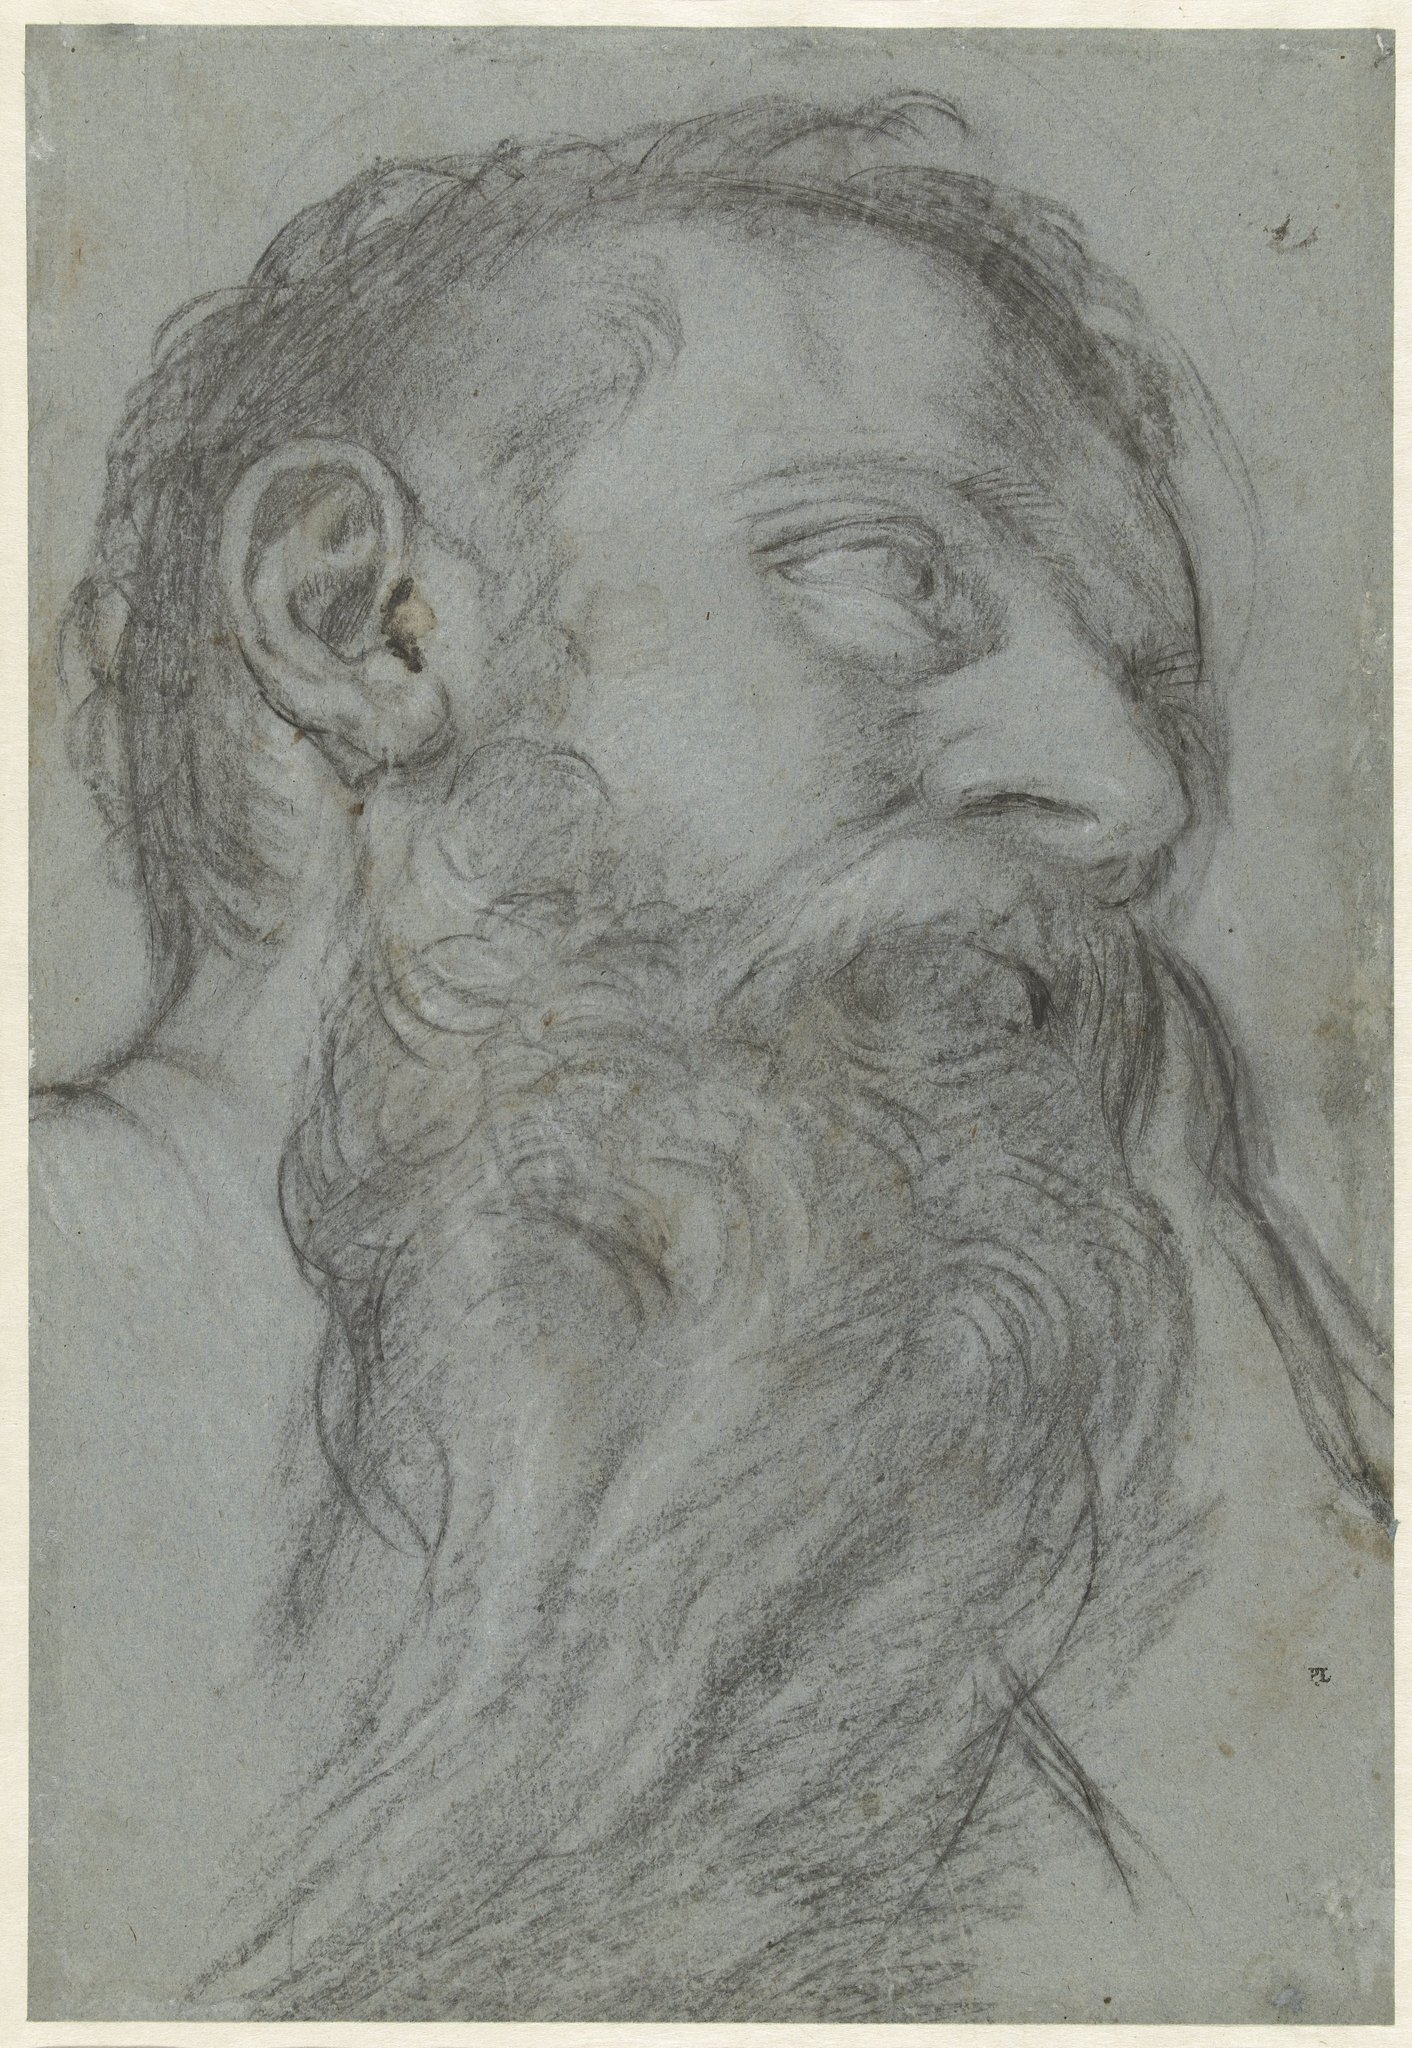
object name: drawing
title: Study of a Head of a Prophet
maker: girolamo muziano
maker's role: draughtsman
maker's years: 1528-1592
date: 1549-1555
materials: chalk, charcoal, paper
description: After training as a landscape artist, Girolamo Muziano concentrated on studying the human body. Altarpieces with many figures provided a better income than landscapes. One of his first commissions in this genre was an altarpiece with Mary and Joseph resting on the flight into Egypt. This drawing is a preparatory study for one of the prophets in a lunette above that painting.